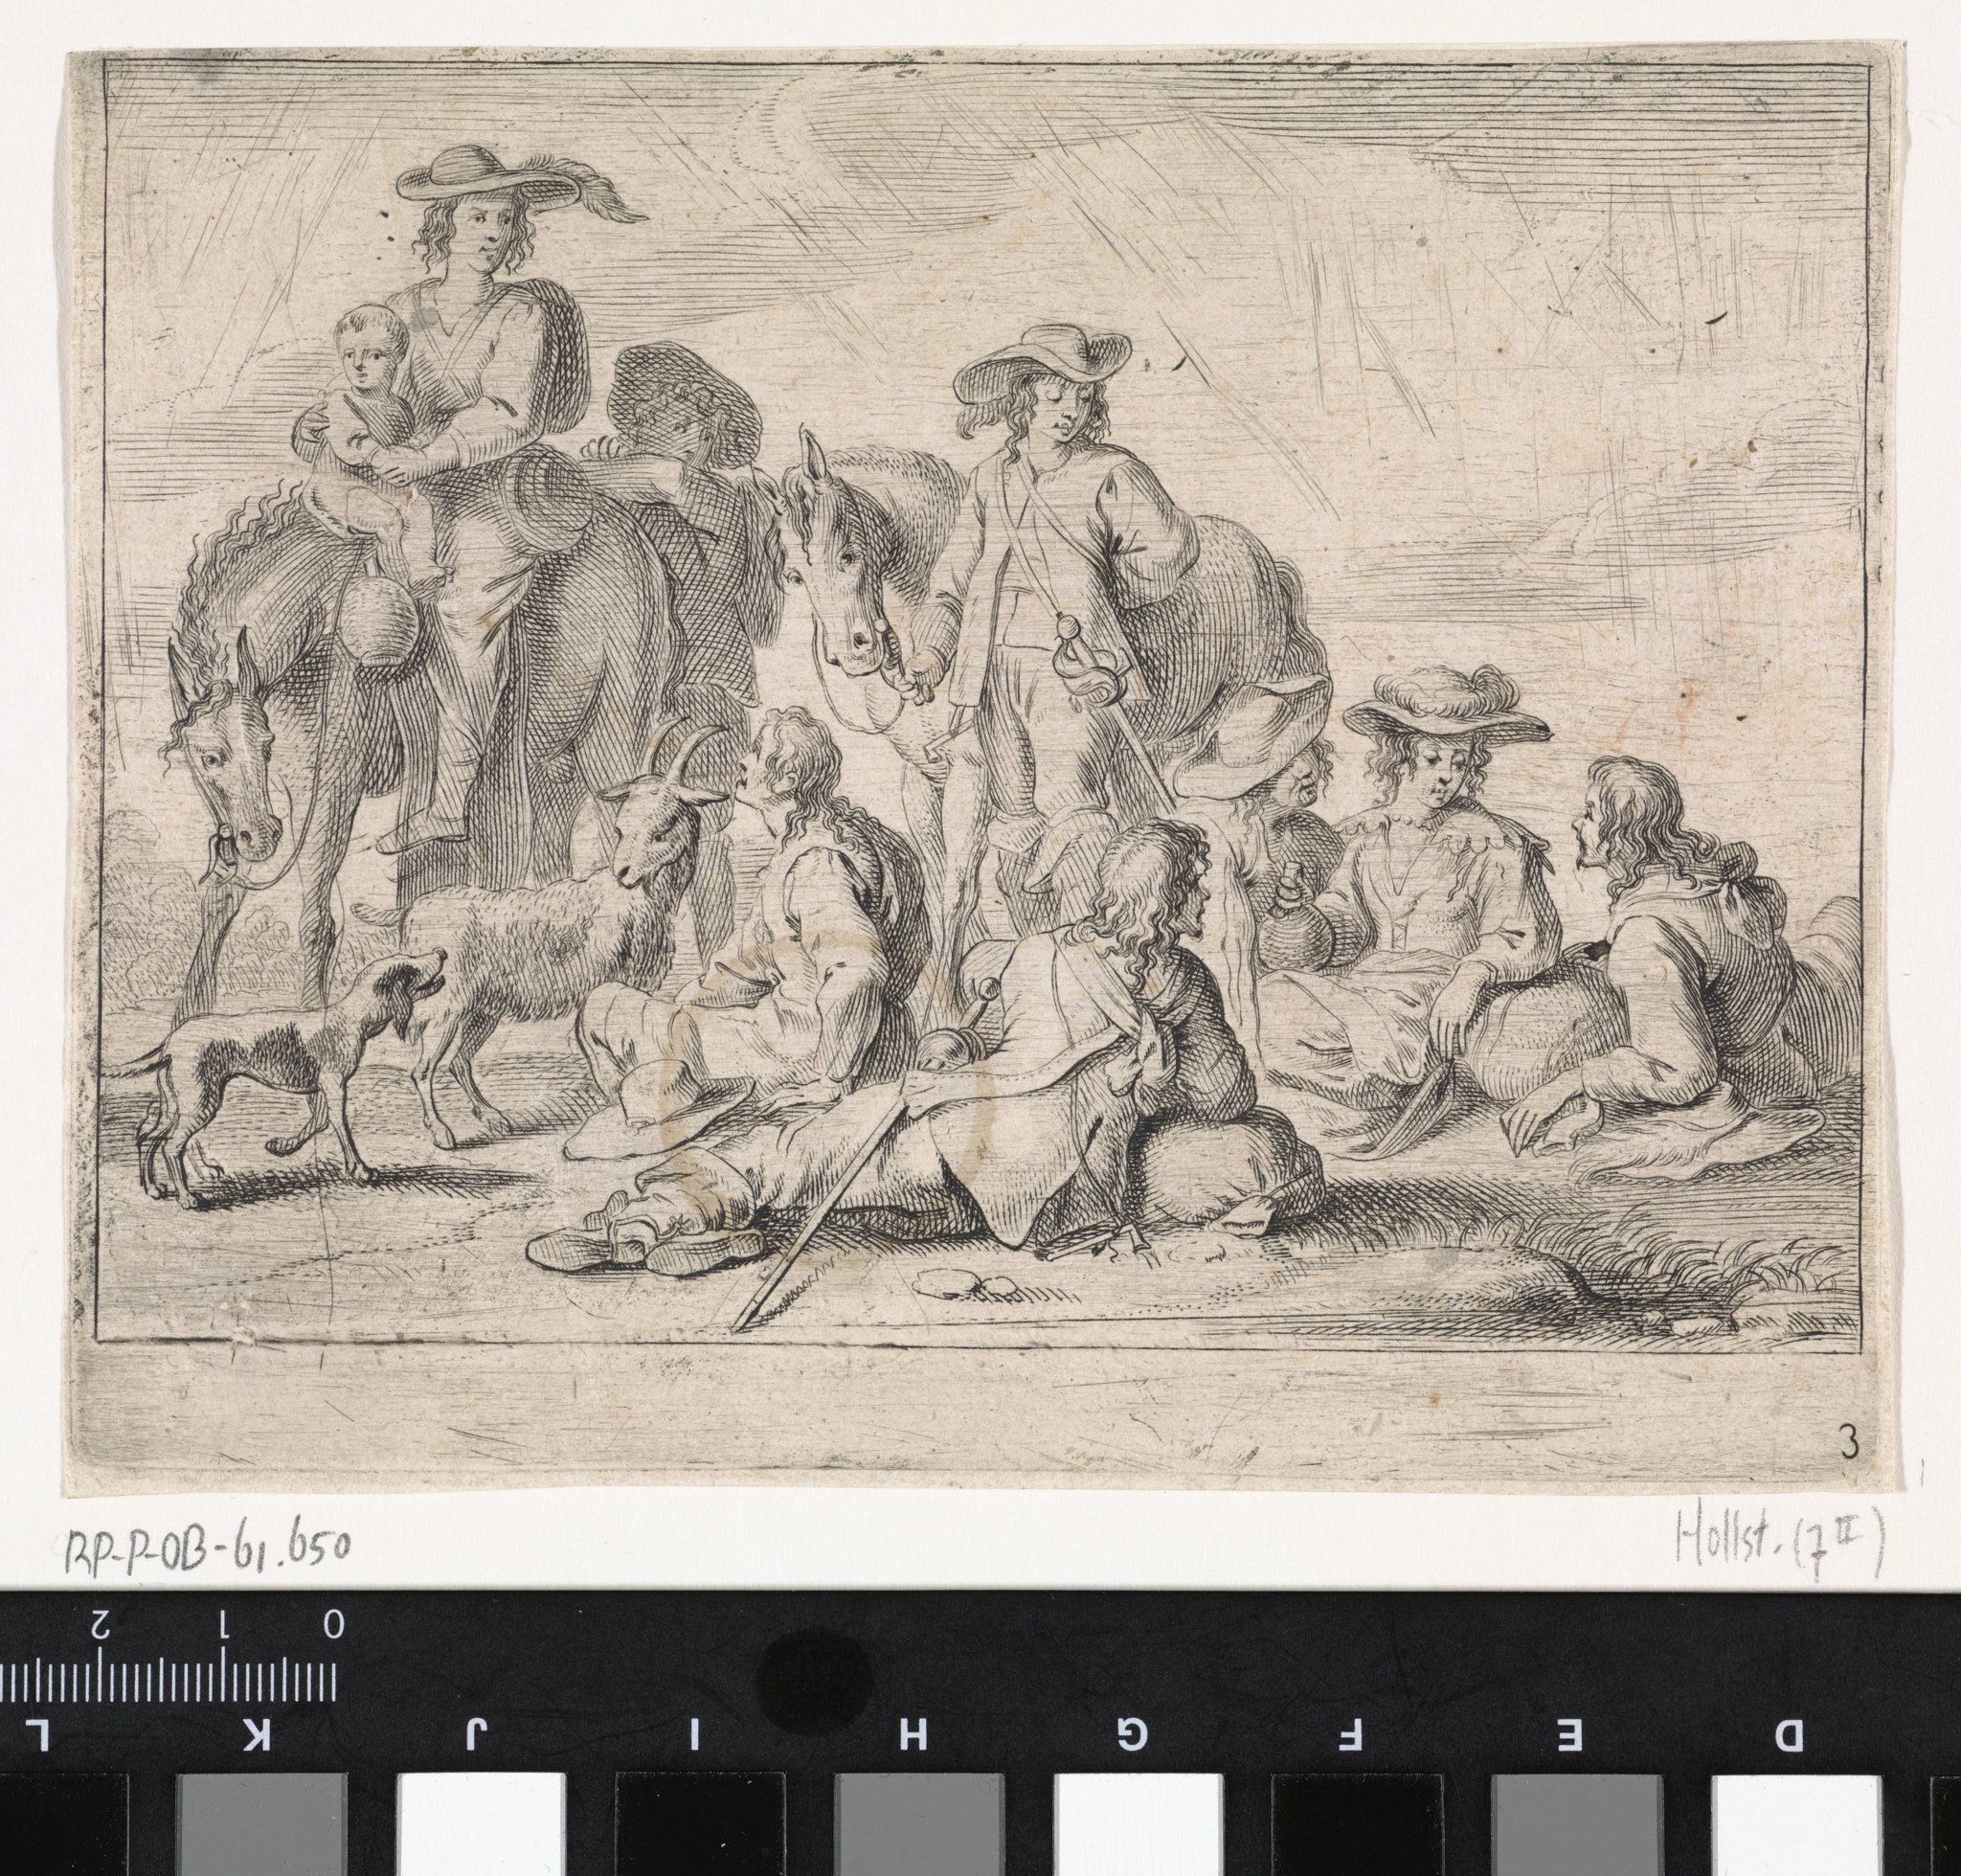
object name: print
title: Genretaferelen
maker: cornelis de wael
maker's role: draughtsman, print maker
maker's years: 1592-1667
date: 1630-1648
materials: paper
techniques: engraving, etching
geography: italy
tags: hunters resting during the hunt, goat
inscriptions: collector's mark: Lugt 240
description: Een groep ruiters neemt een pauze. Ze zijn met elkaar in gesprek. Eén vrouw zit nog met haar kind op het paard. Links een geit en een hond.